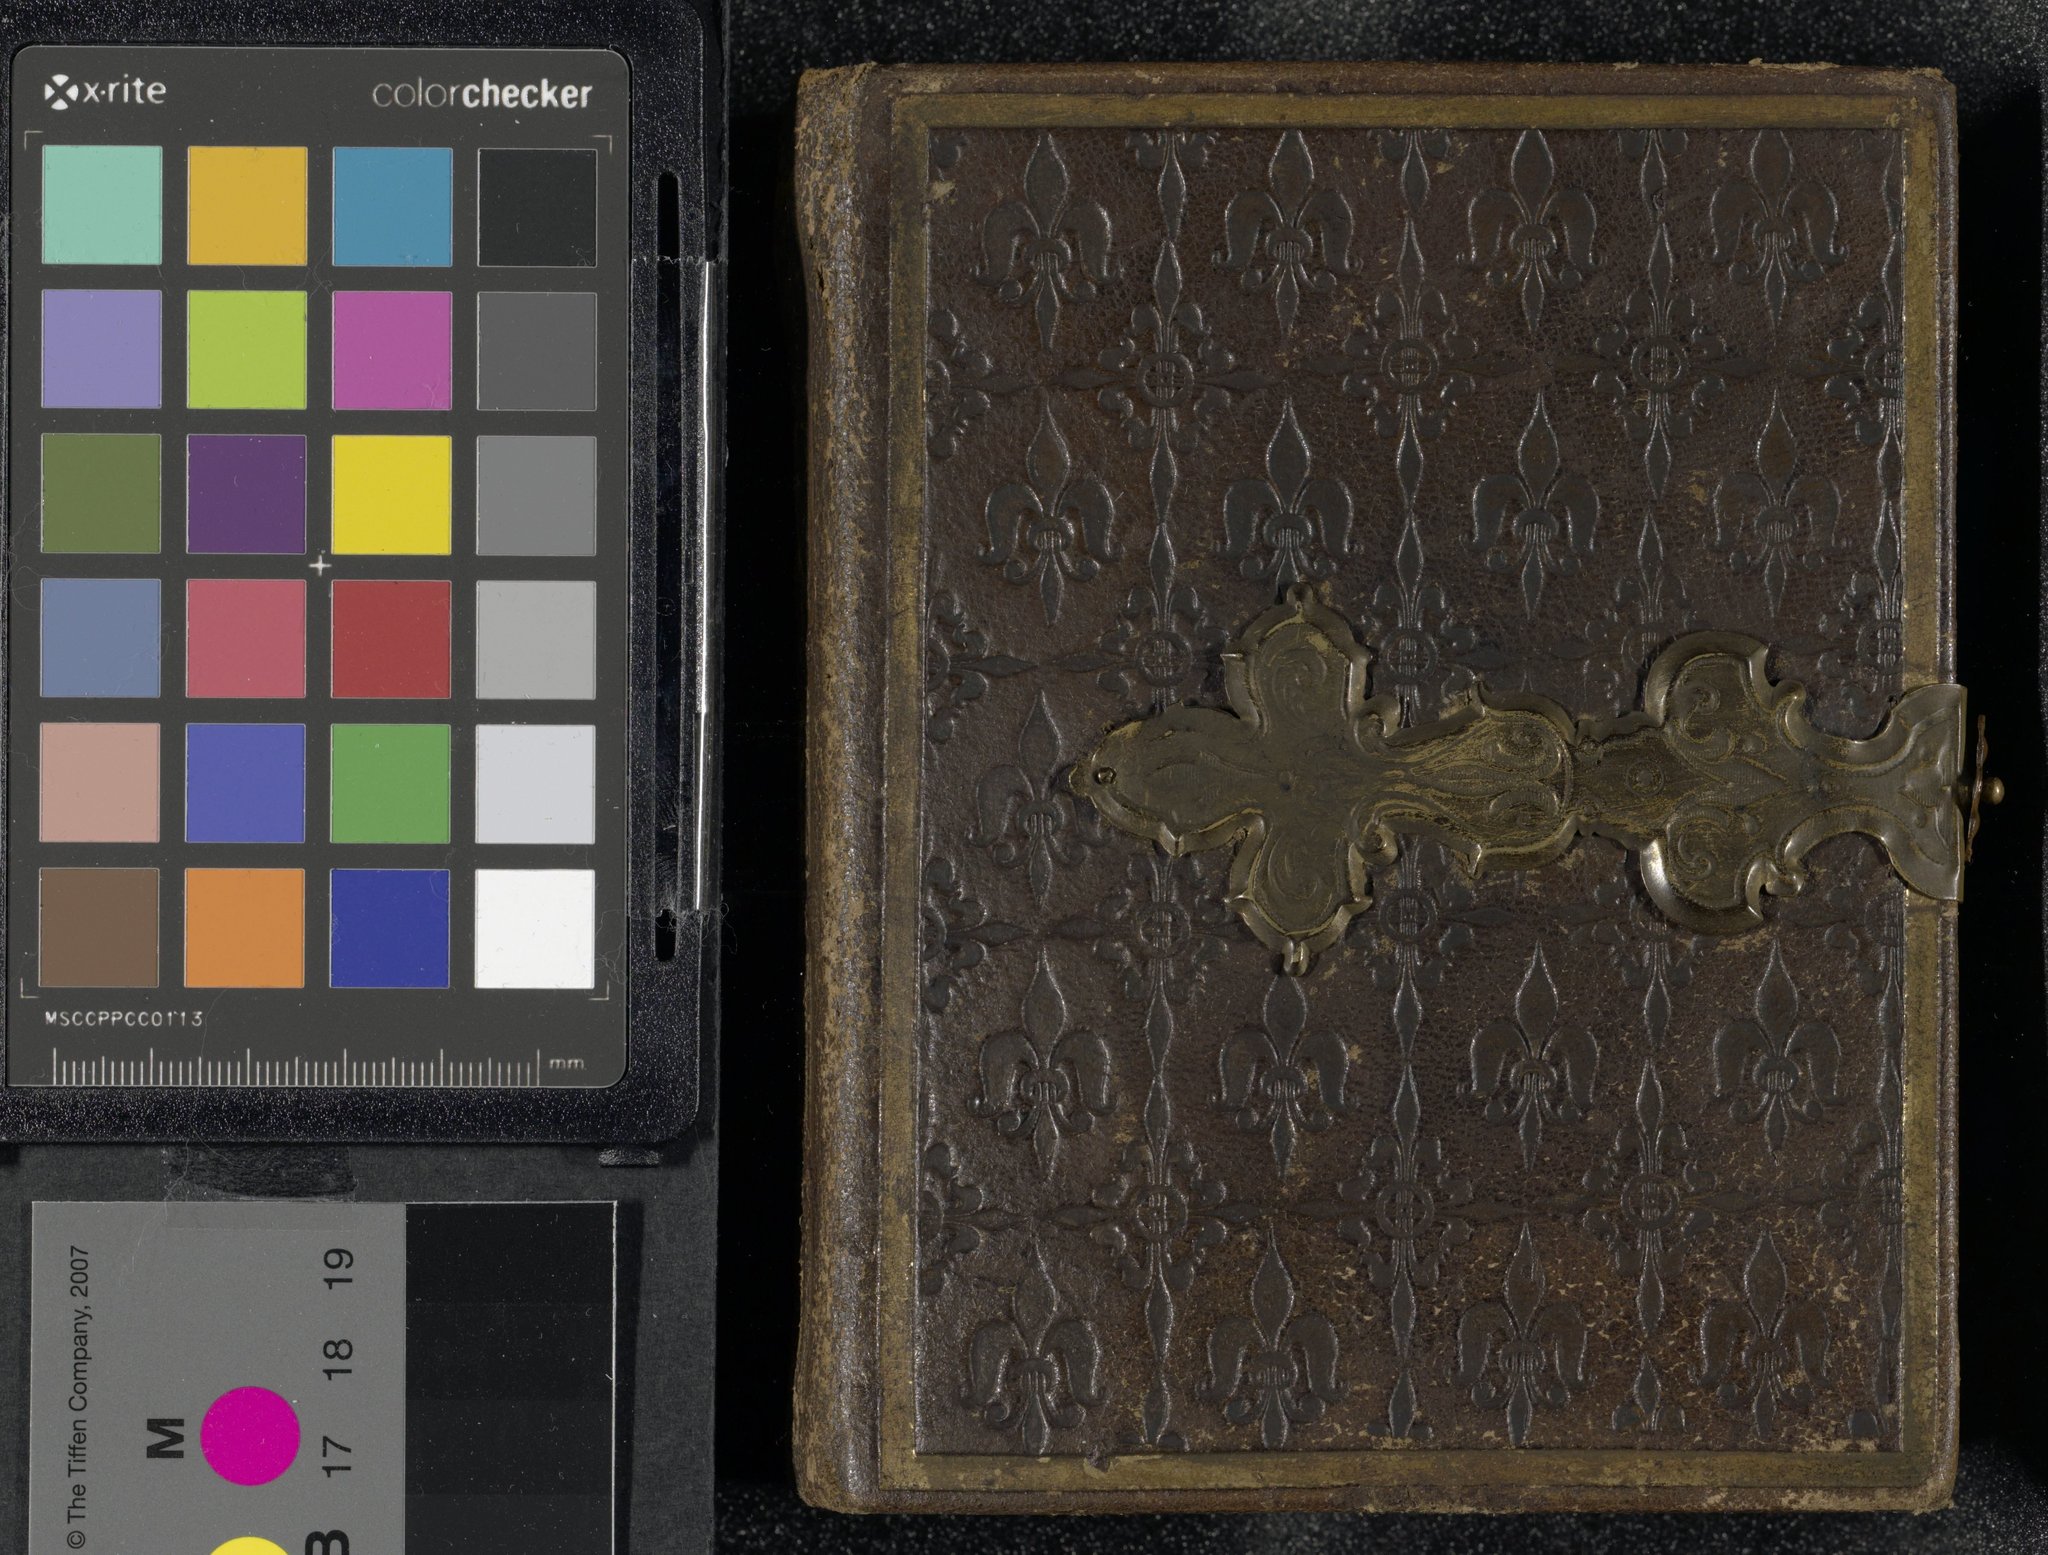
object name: slip in album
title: Engels fotoalbum van E.A. Kettle met 42 cartes-de-visite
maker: e.a. kettle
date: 1863-1889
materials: cardboard, copper, leather, paper, photographic support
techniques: albumen print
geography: england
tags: studio requisites ~ photographer, historical persons, family, relationship, descent, hairdress, clothes, costume, england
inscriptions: inscription: ‘E.A. Kettle April 5th 1863’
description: Fotoalbum in bruin leren omslag met koperen slot in lelievorm. De voor- en achterzijde zijn versierd met leliemotieven in reliëf. Schutbladen van sierpapier met geometrische en bloemmotieven. Op het schutblad is met de hand 'E. A. Kettle April 5th 1863' geschreven. Het album bevat 20 dikke kartonnen bladen met goud op snee. Elke pagina heeft een met goudkleurige lijnen omkaderde passe-partout. In totaal 42 cartes-de-visite van verschillende fotografen. Twee cartes-de visite liggen los in het album. Op een aantal pagina's is een naam en een jaartal geschreven. Het betreft leden van de familie Kettle.